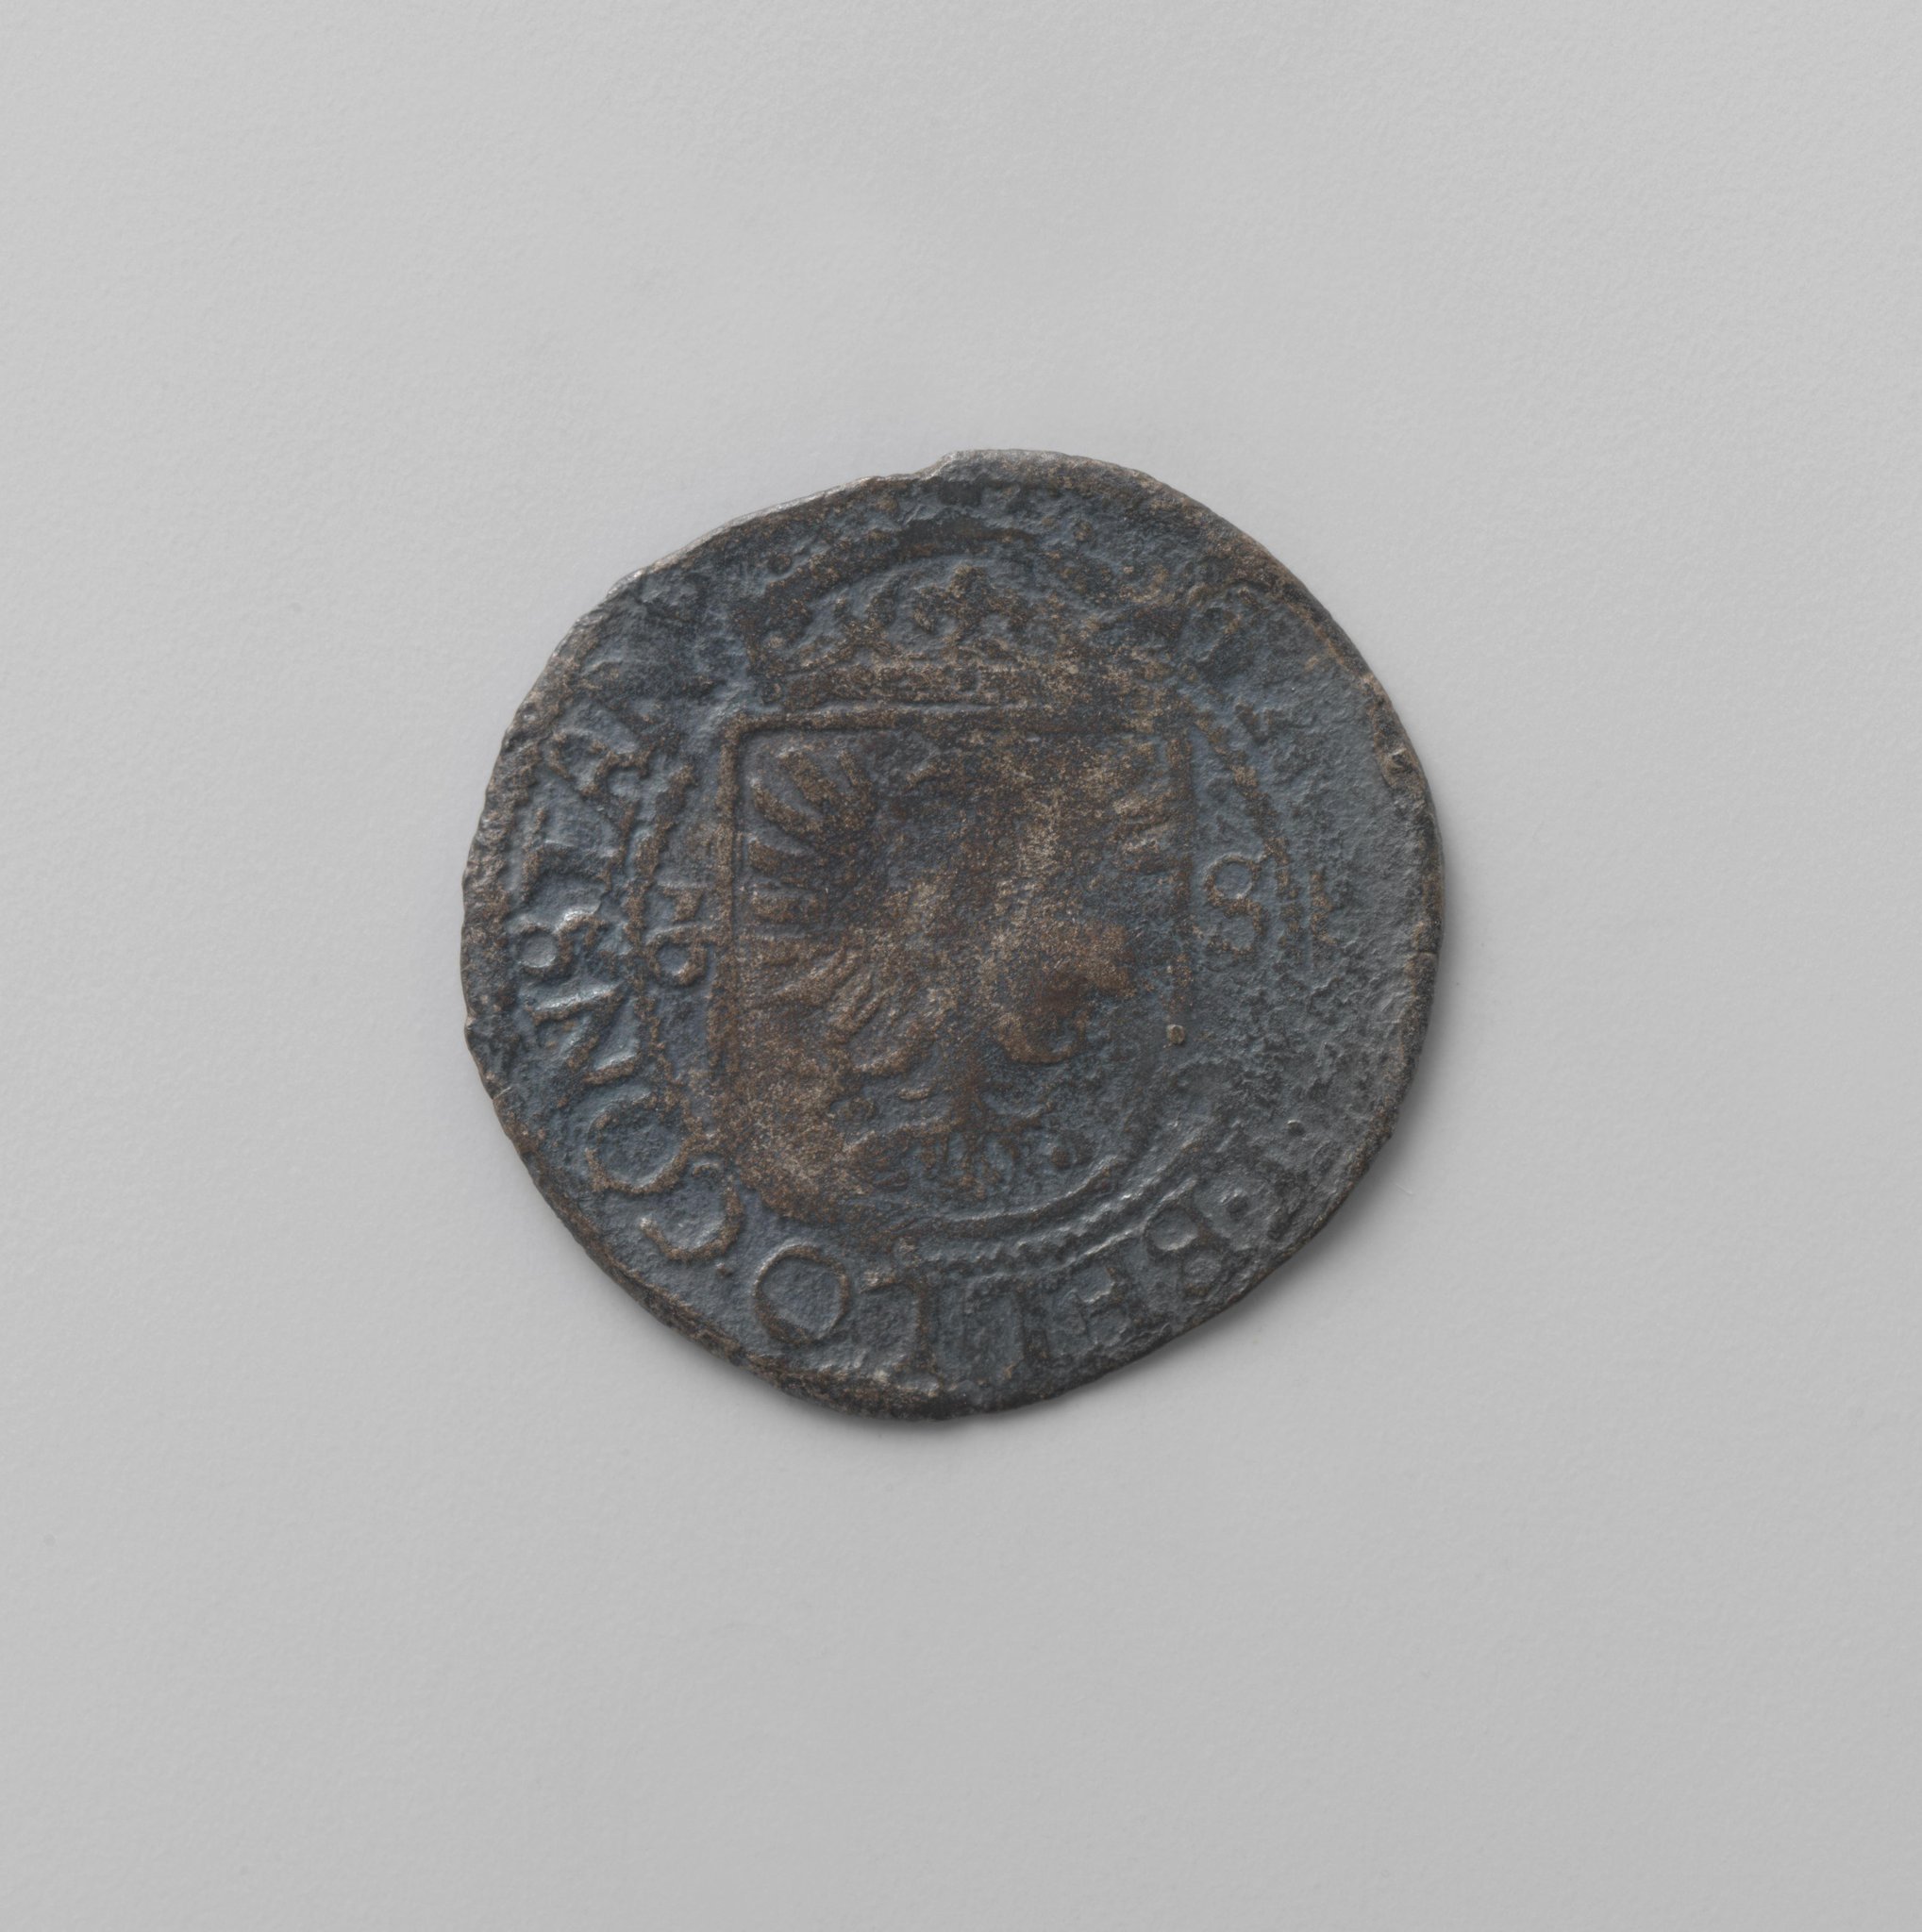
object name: coin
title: Deventer, halve stuiver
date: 1628-1630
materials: silver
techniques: striking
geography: deventer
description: Zilveren munt. Voorzijde: tussen waarde-aanduiding 1/2 S gekroond wapenschild van Deventer. Keerzijde: lang versierd kruis met in de hoeken letters H, S, D en E.